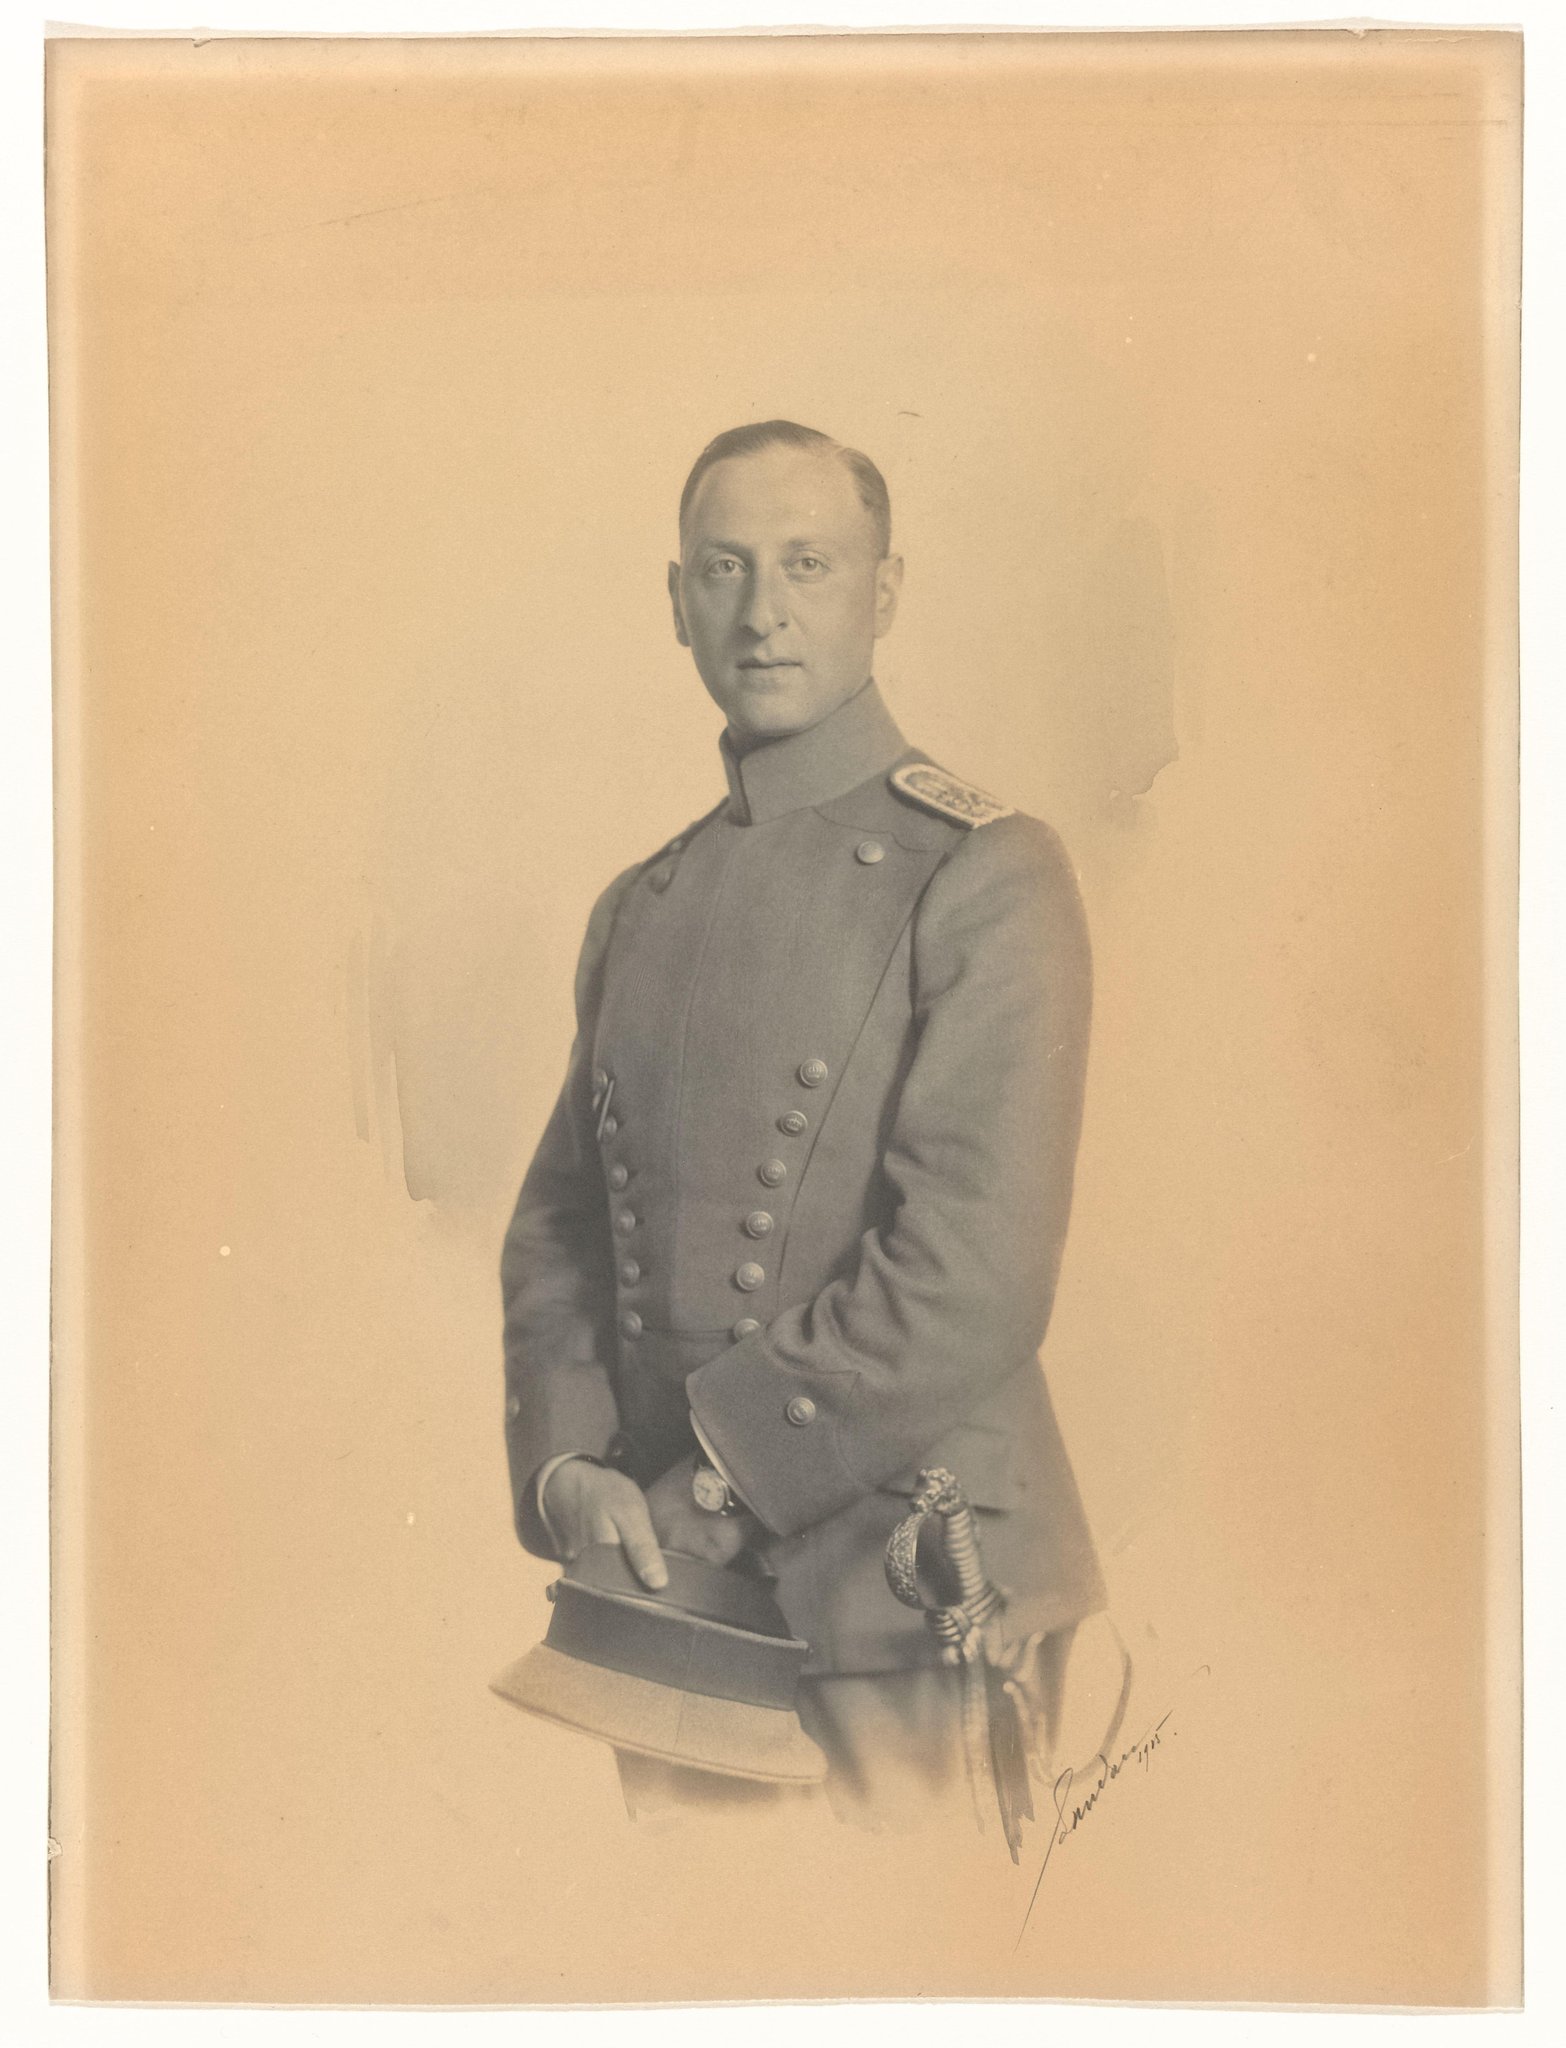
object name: photograph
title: Arthur Moos met sabel in het uniform van het Duitse leger, Landau, 1905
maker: Anonymous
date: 1905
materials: photographic support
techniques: gelatin silver print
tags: arthur moos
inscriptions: inscription: ‘Landau 1905’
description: Arthur Moos in het uniform van het Duitse leger.